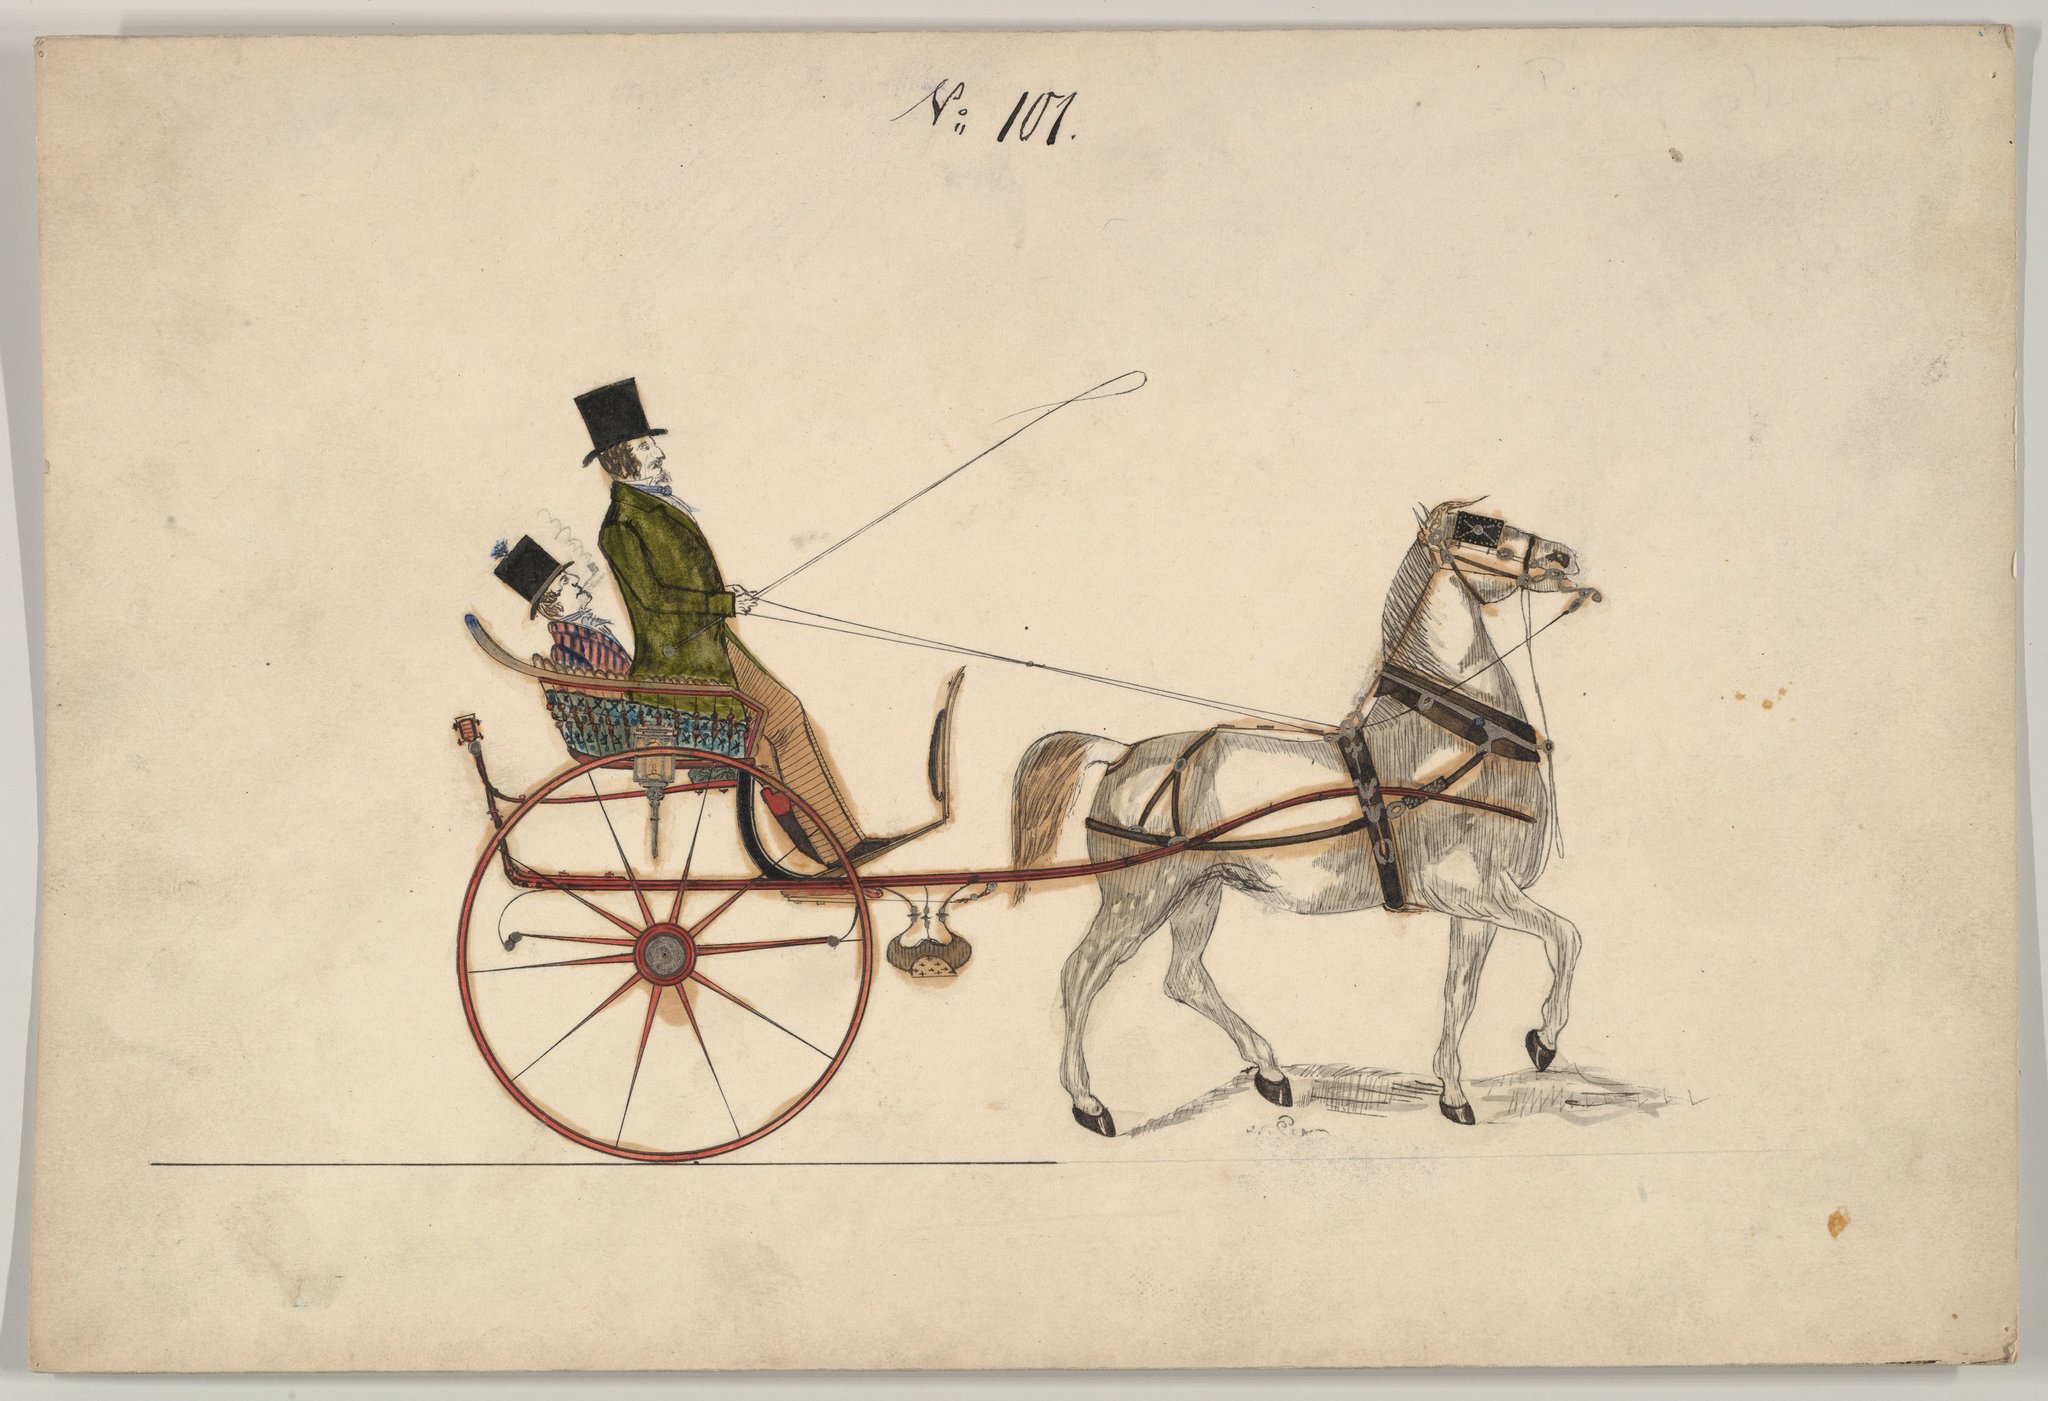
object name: drawing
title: Tilbury #101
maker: brewster & co.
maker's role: manufacturer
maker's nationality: american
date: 1860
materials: gouache, ink, watercolor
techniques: pen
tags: men,smoking,horses,carriages